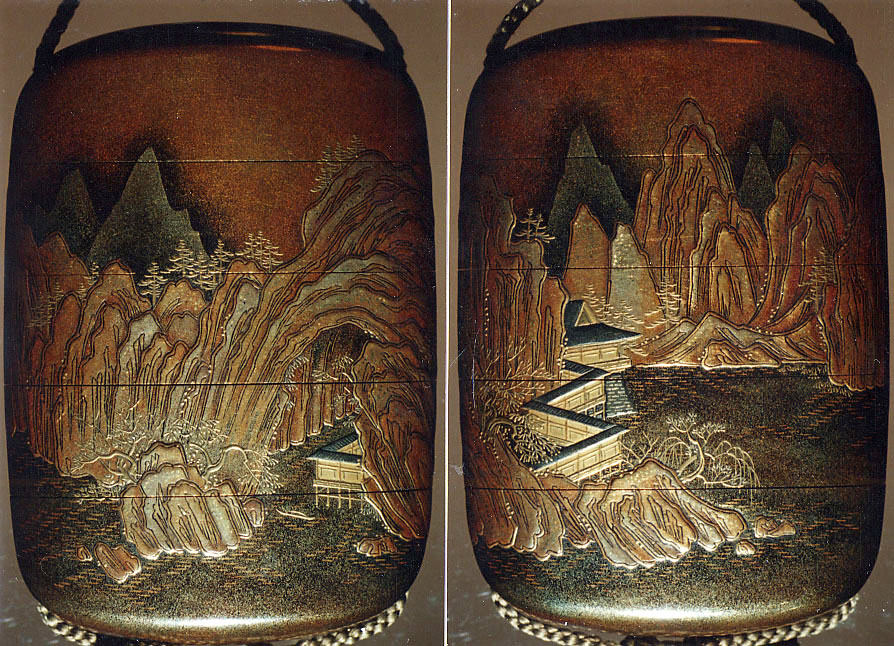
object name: inrō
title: Case (Inrō) with Design of Chinese-Style Mountain Landscape with Buildings beside Rocks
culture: japanese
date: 1801-1900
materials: gold, lacquer, silver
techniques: fundame, hiramakie, maki-e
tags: buildings,mountains,landscapes